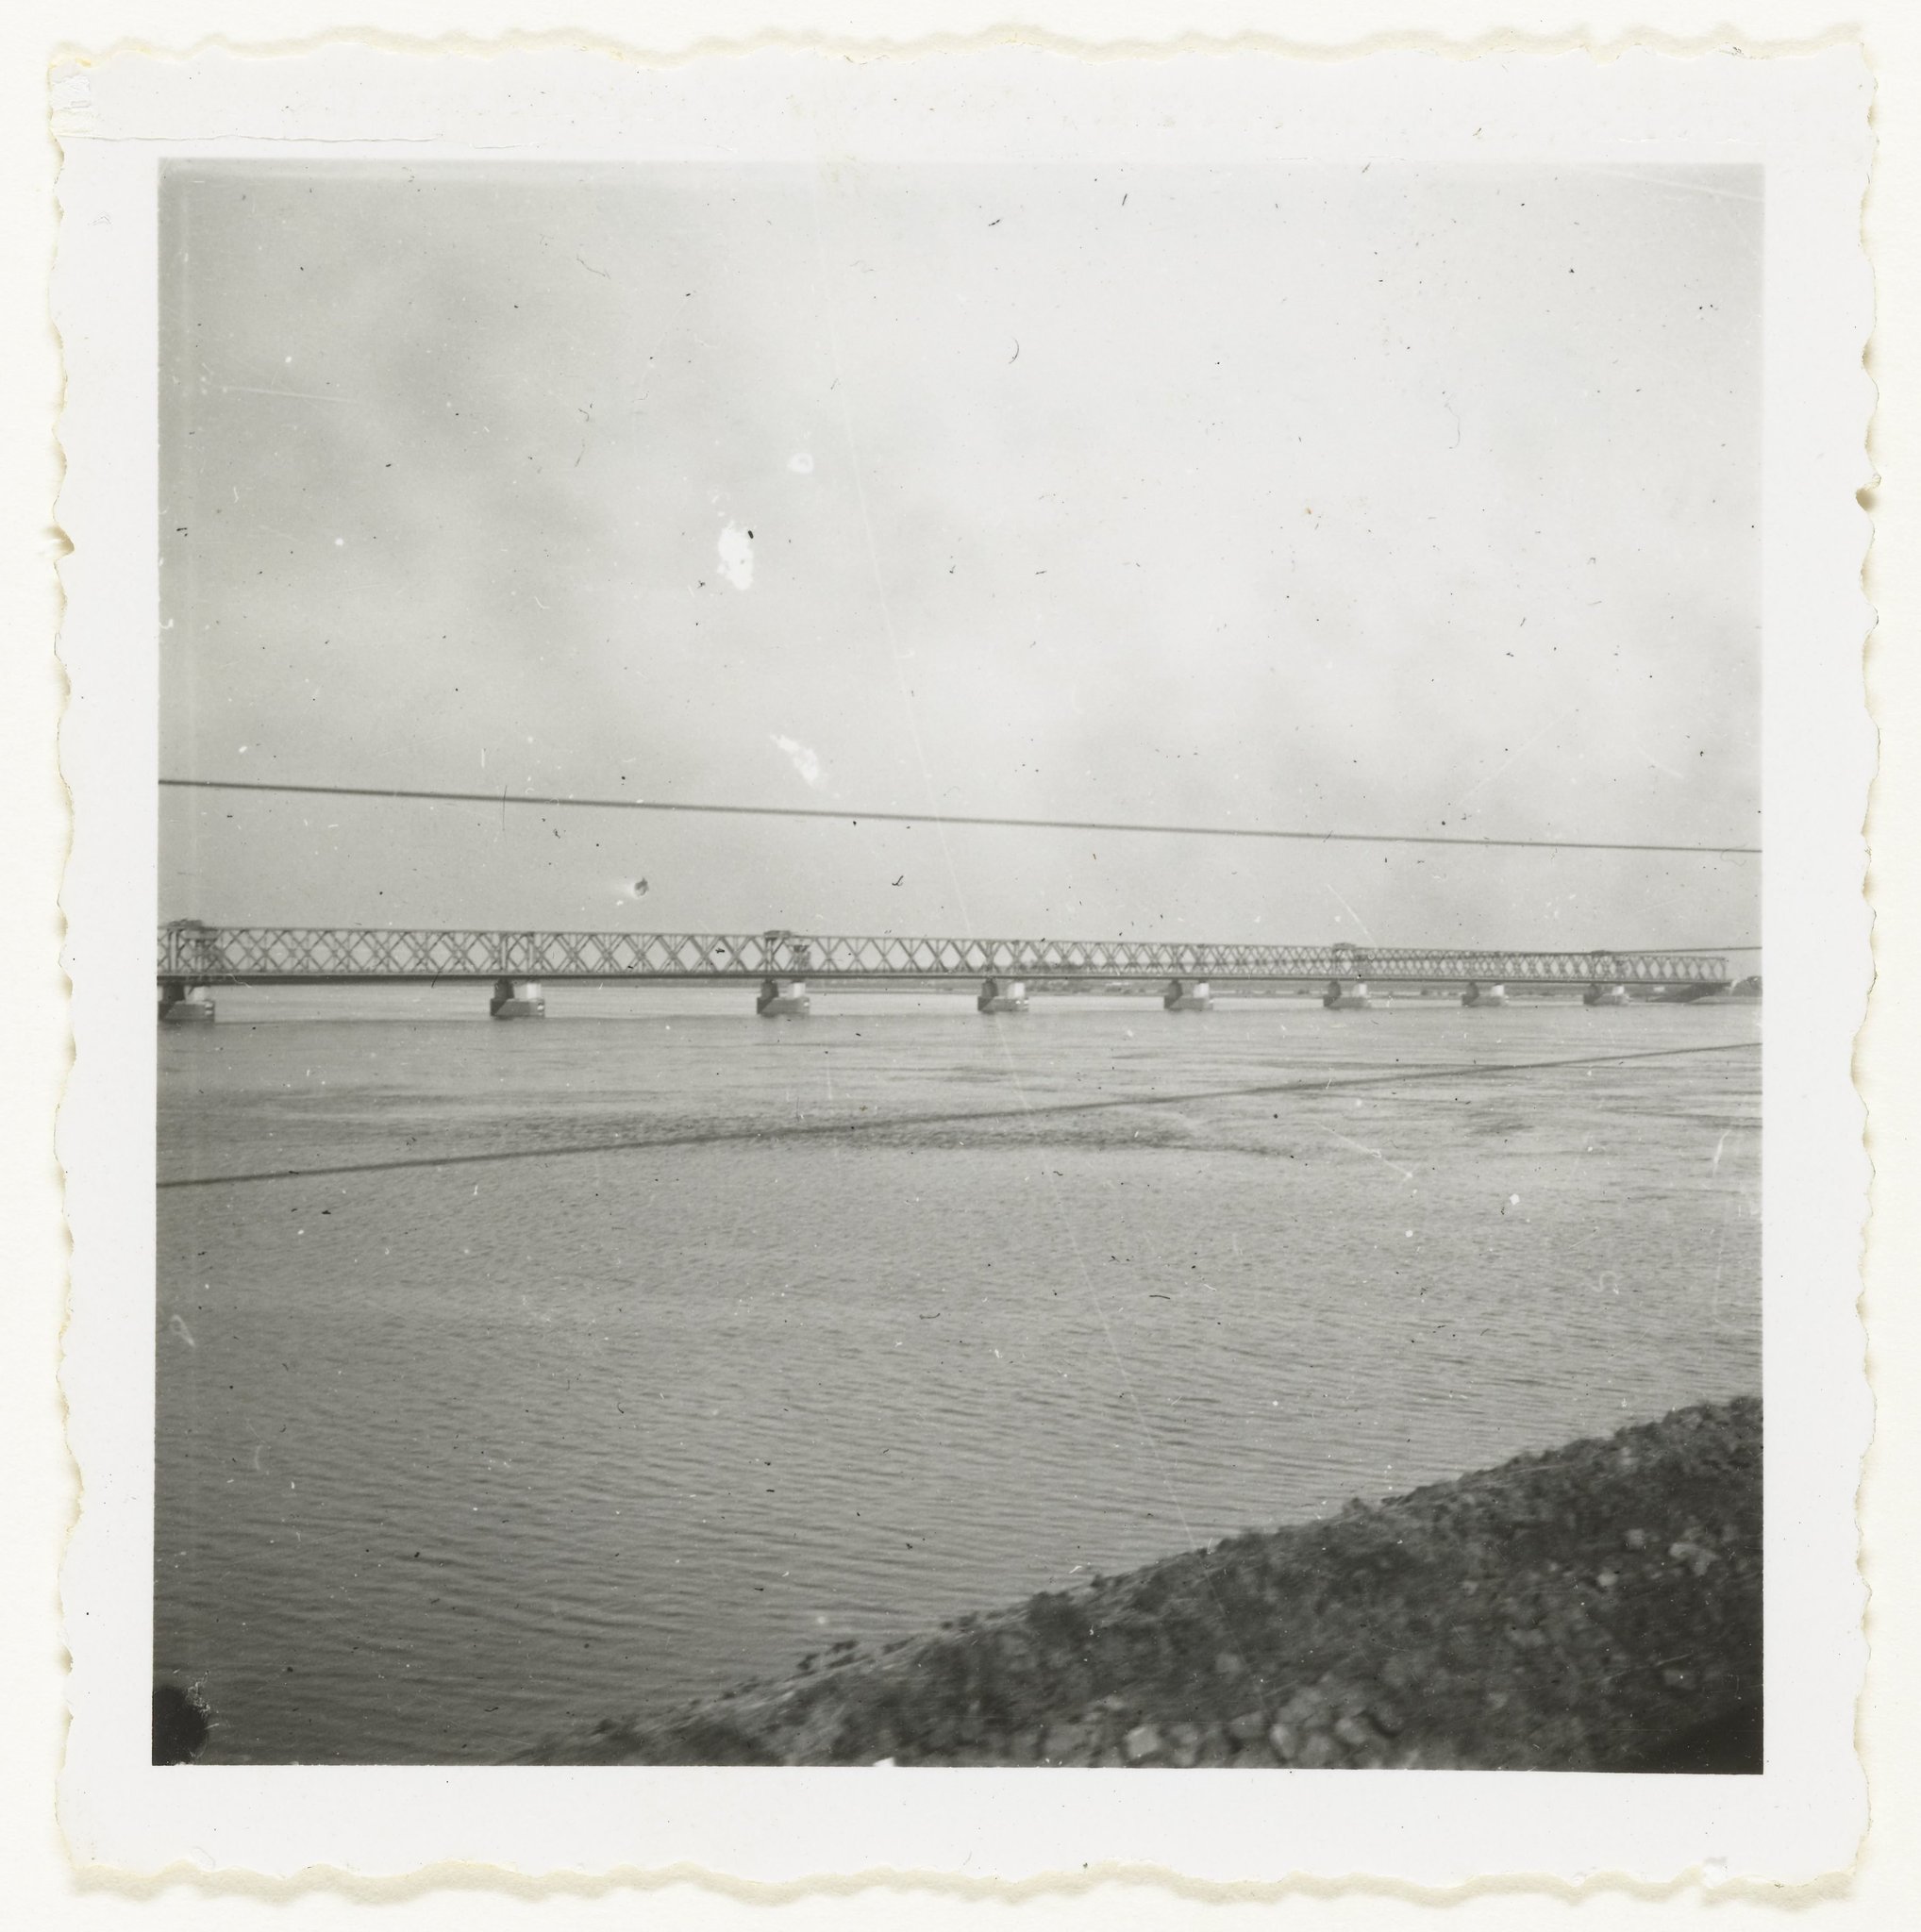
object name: photograph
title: Moerdijk brug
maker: Anonymous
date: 1941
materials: photographic support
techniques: gelatin silver print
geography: moerdijk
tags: bridge, occupation ~ war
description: Moerdijkbrug gefotografeerd vanaf een afstand.